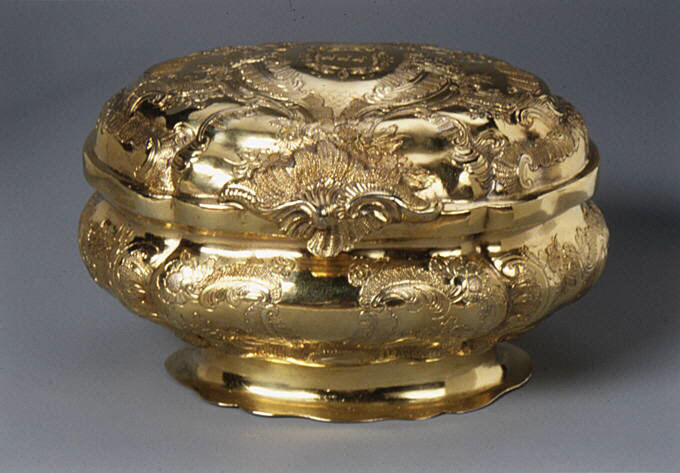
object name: box with cover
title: Small oval box with cover (one of a pair)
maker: johann martin satzger i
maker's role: maker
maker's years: 1707-1785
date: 1755-1757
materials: silver gilt